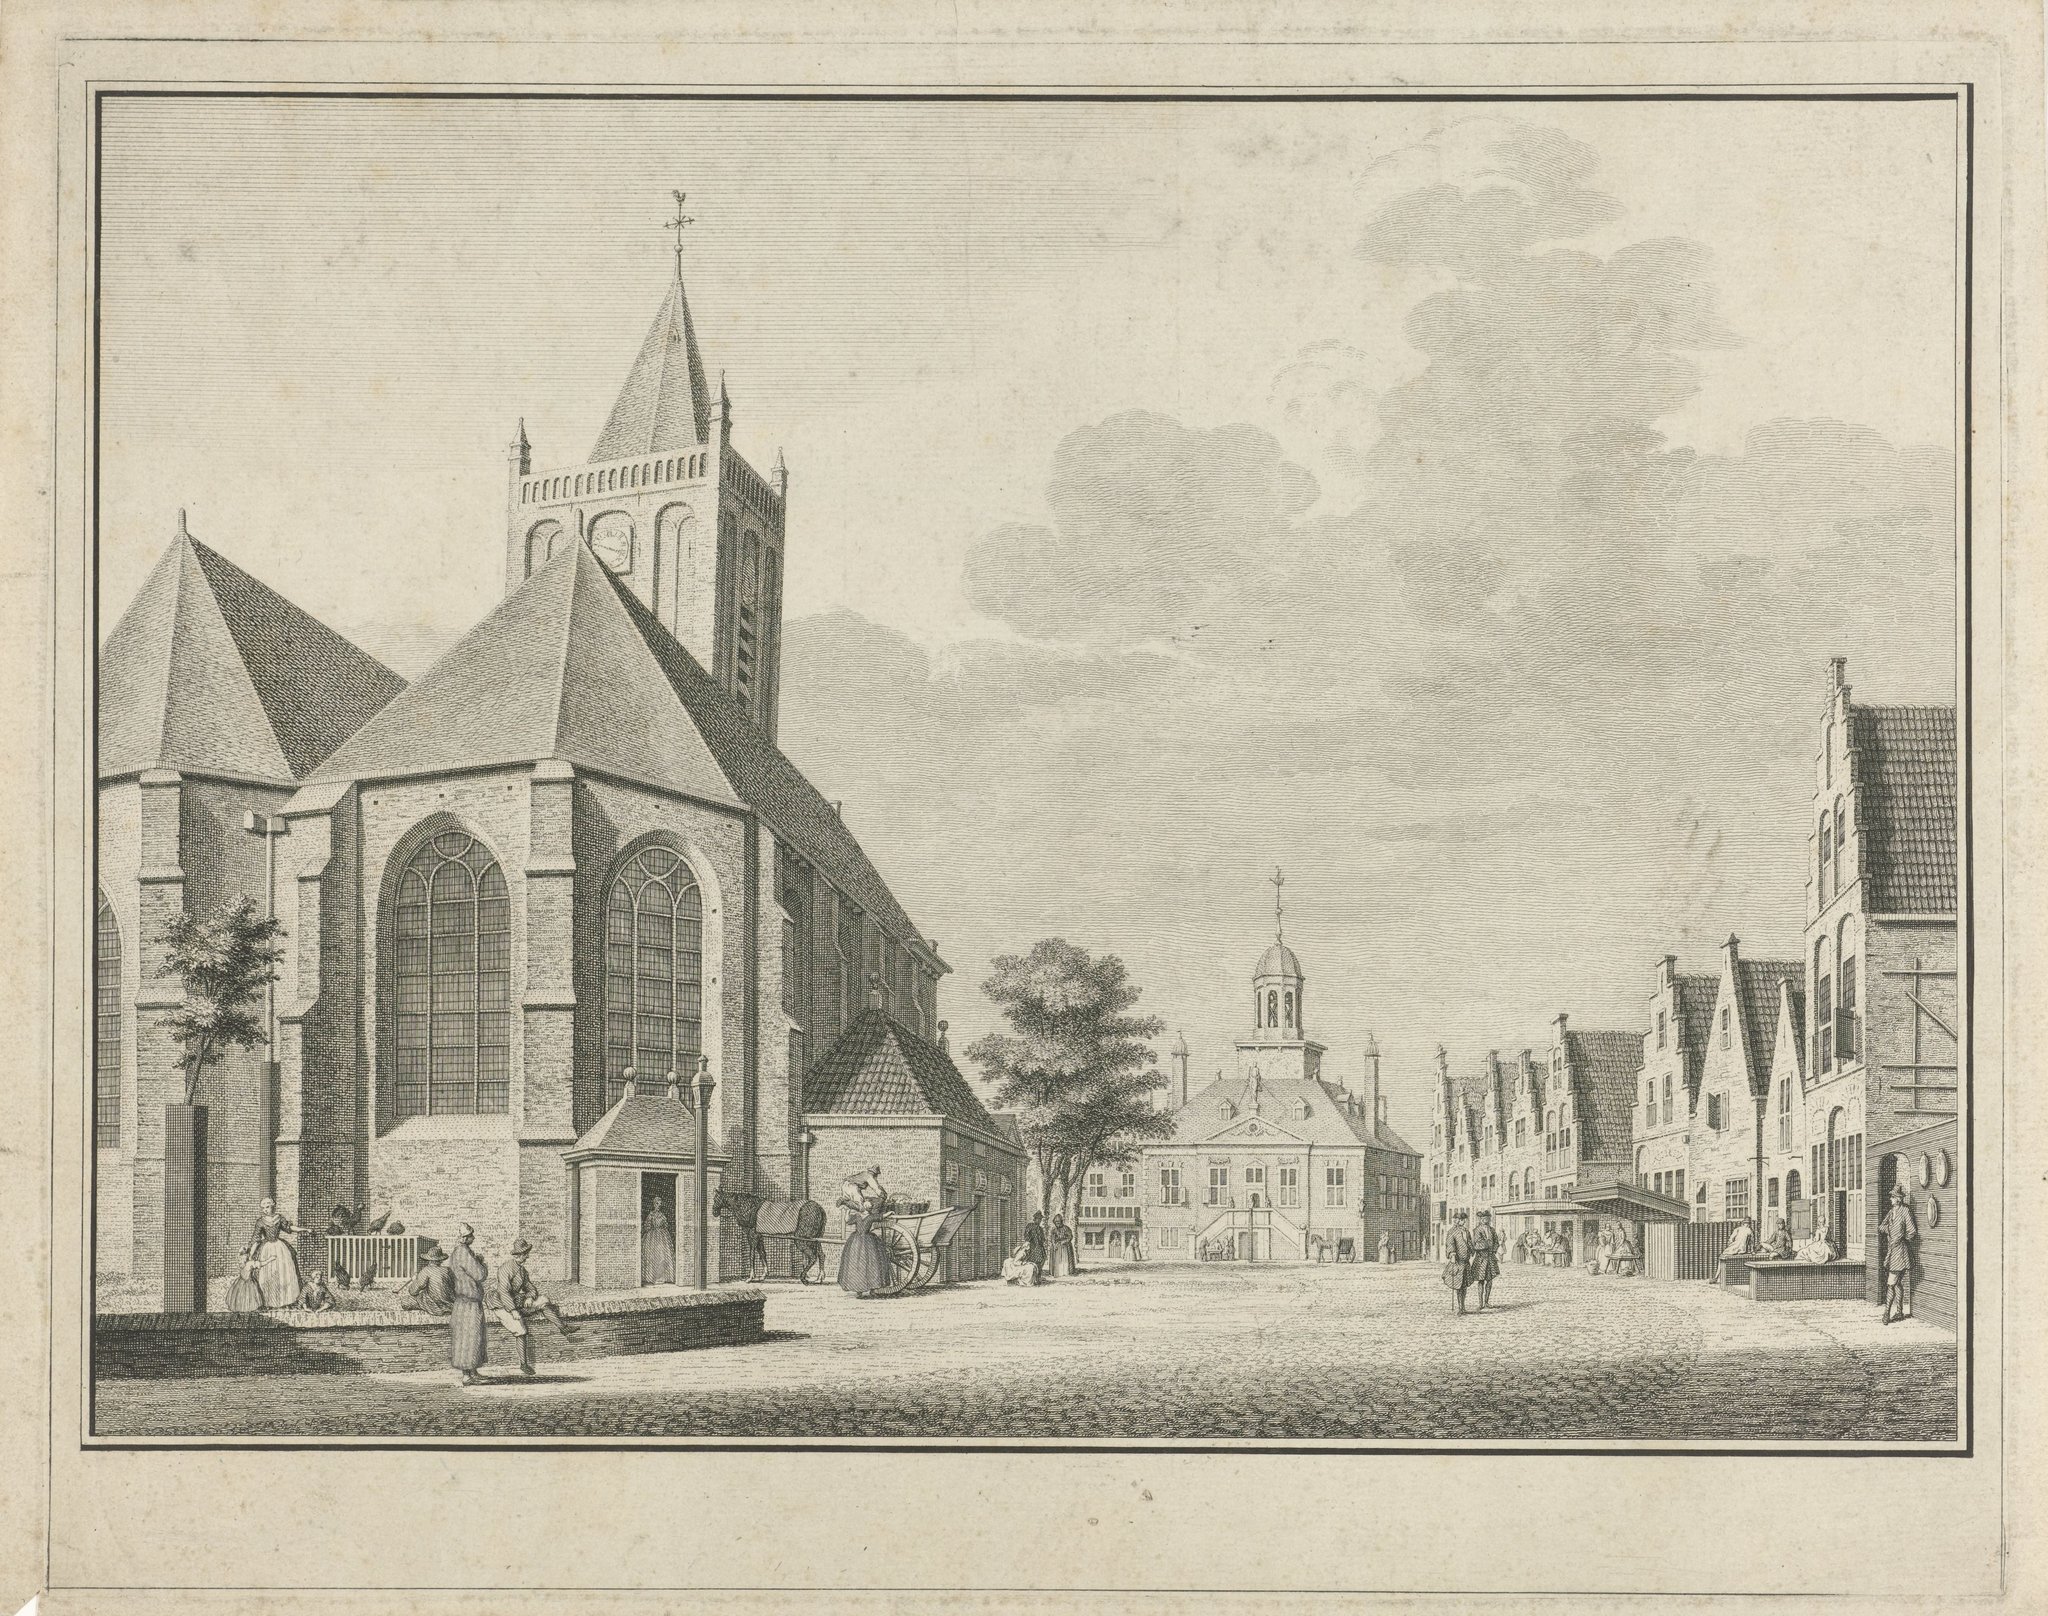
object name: print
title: Gezicht op de Grote Kerk en het Oude Stadhuis aan de Markt te Vlaardingen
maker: jan caspar philips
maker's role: draughtsman, print maker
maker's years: 1700-1775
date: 1743-1744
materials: paper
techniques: engraving, etching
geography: amsterdam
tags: church (exterior), townhall, market, village square, place (+ city(-scape) with figures, staffage)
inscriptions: collector's mark: Lugt 2228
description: Latere staat van prent ook gebruikt in: Handvesten, octroyen, privilegien en regten, aan de stede Vlaardingen (…) en met der stede grondteekening en andere kopere plaaten verçiert (…). Den Haag: Johannes Gaillard, 1772. En in: Handvesten, octroyen, privilegien en regten, aan de stede Vlaardingen (…) en met der stede grondteekening en andere kopere plaaten verçiert (…). Utrecht: Johannes van Schoonhoven, 1775.